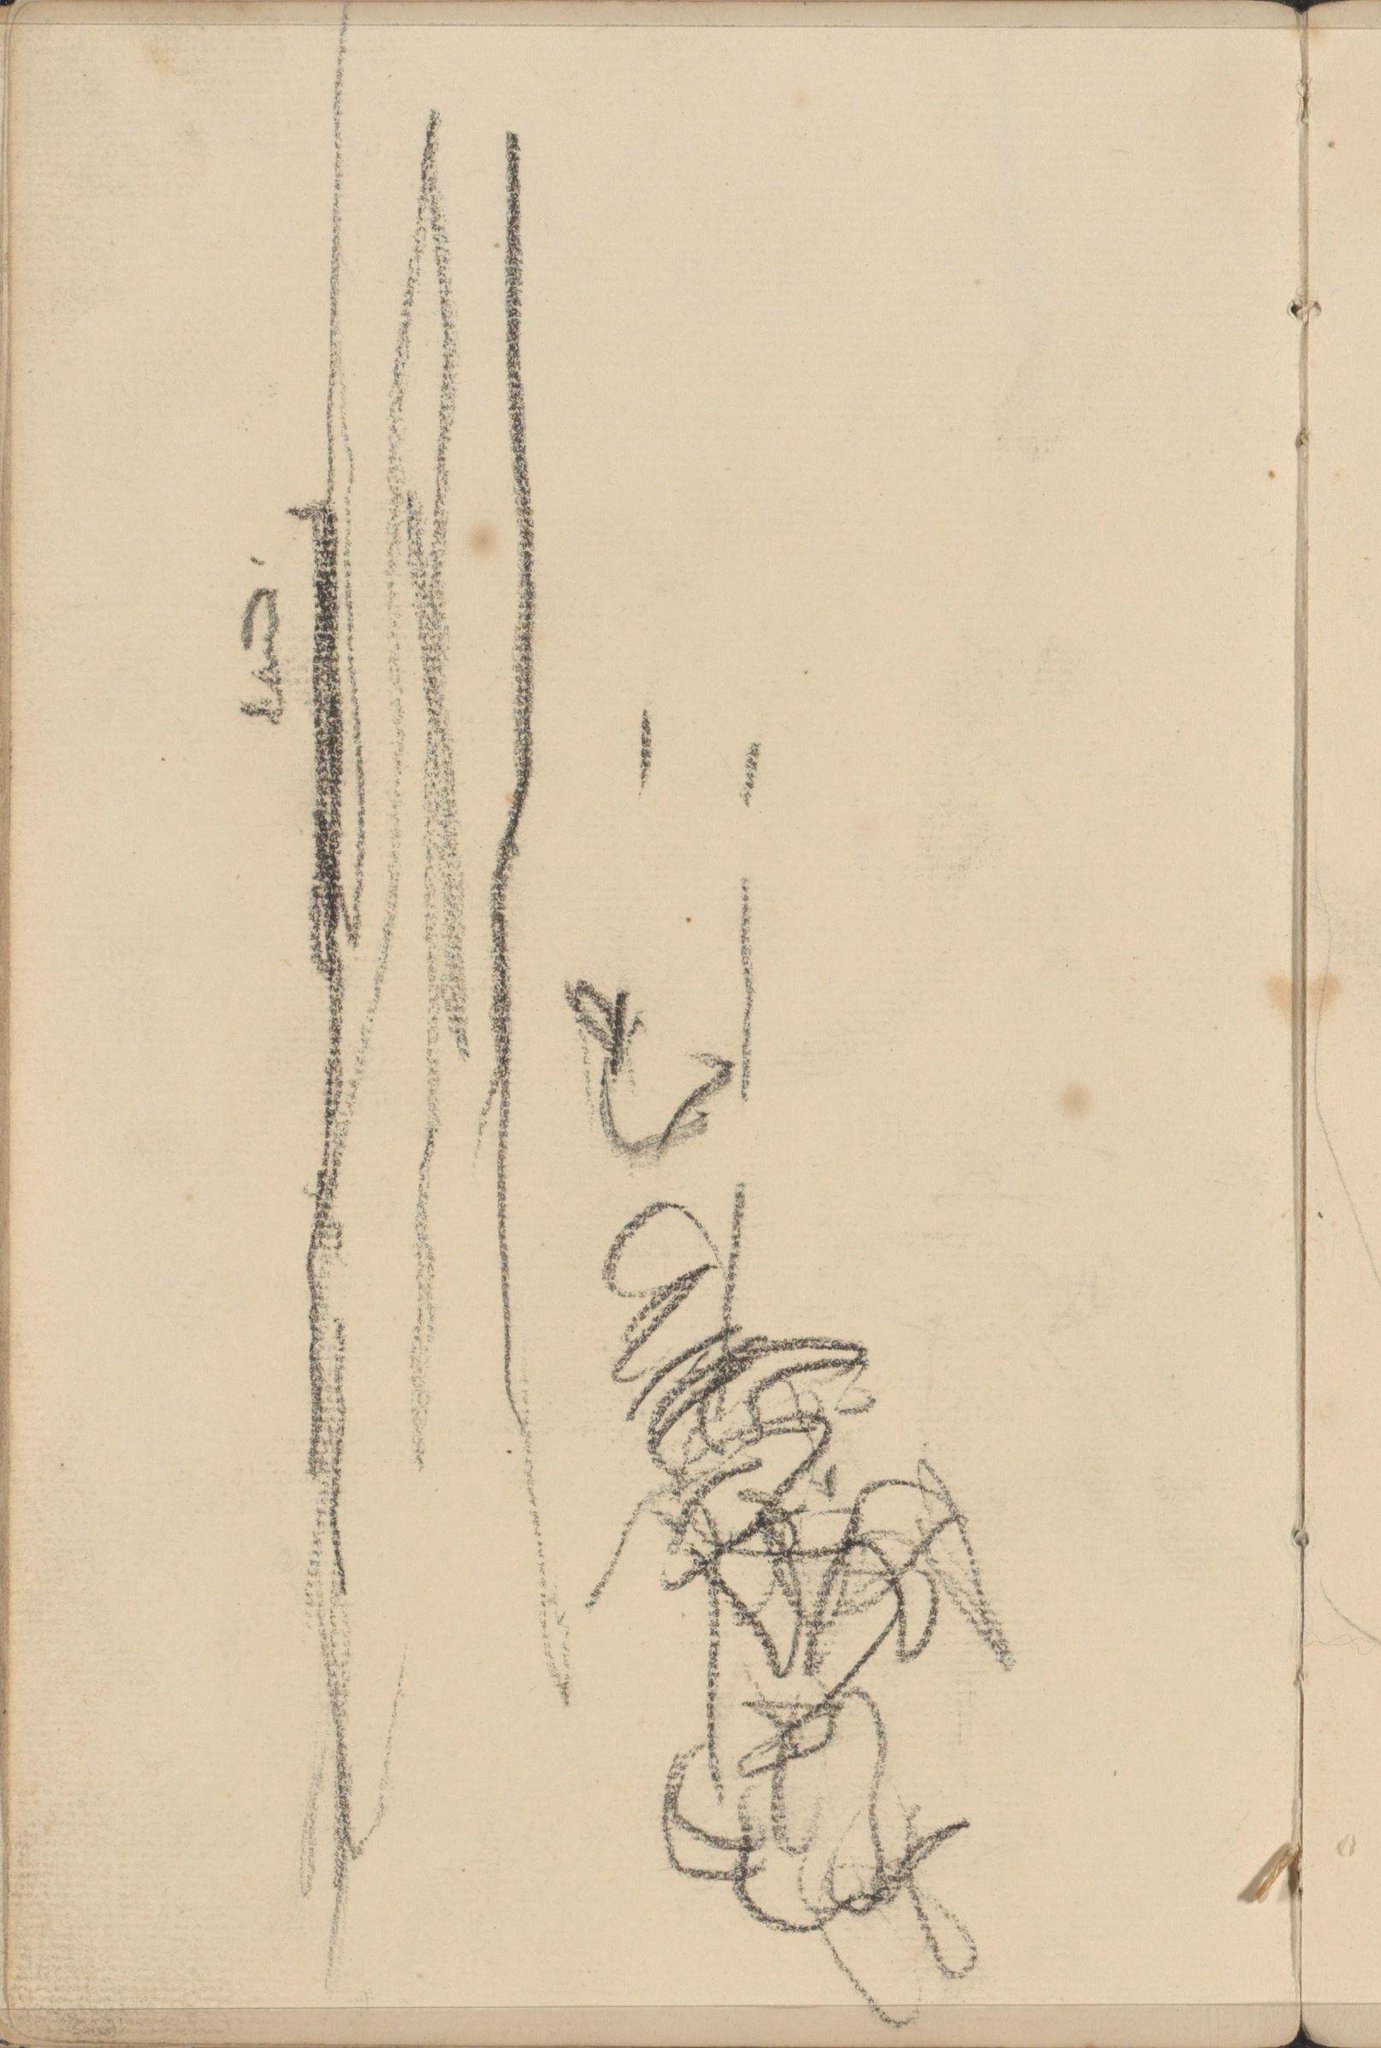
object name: sketchbook leaf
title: Landschap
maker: george hendrik breitner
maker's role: draughtsman, painter, print maker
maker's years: 1857-1923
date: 1904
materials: chalk, paper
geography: arnhem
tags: landscapes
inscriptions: annotation: ‘zand’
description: Pagina 11 uit een schetsboek met 14 bladen.